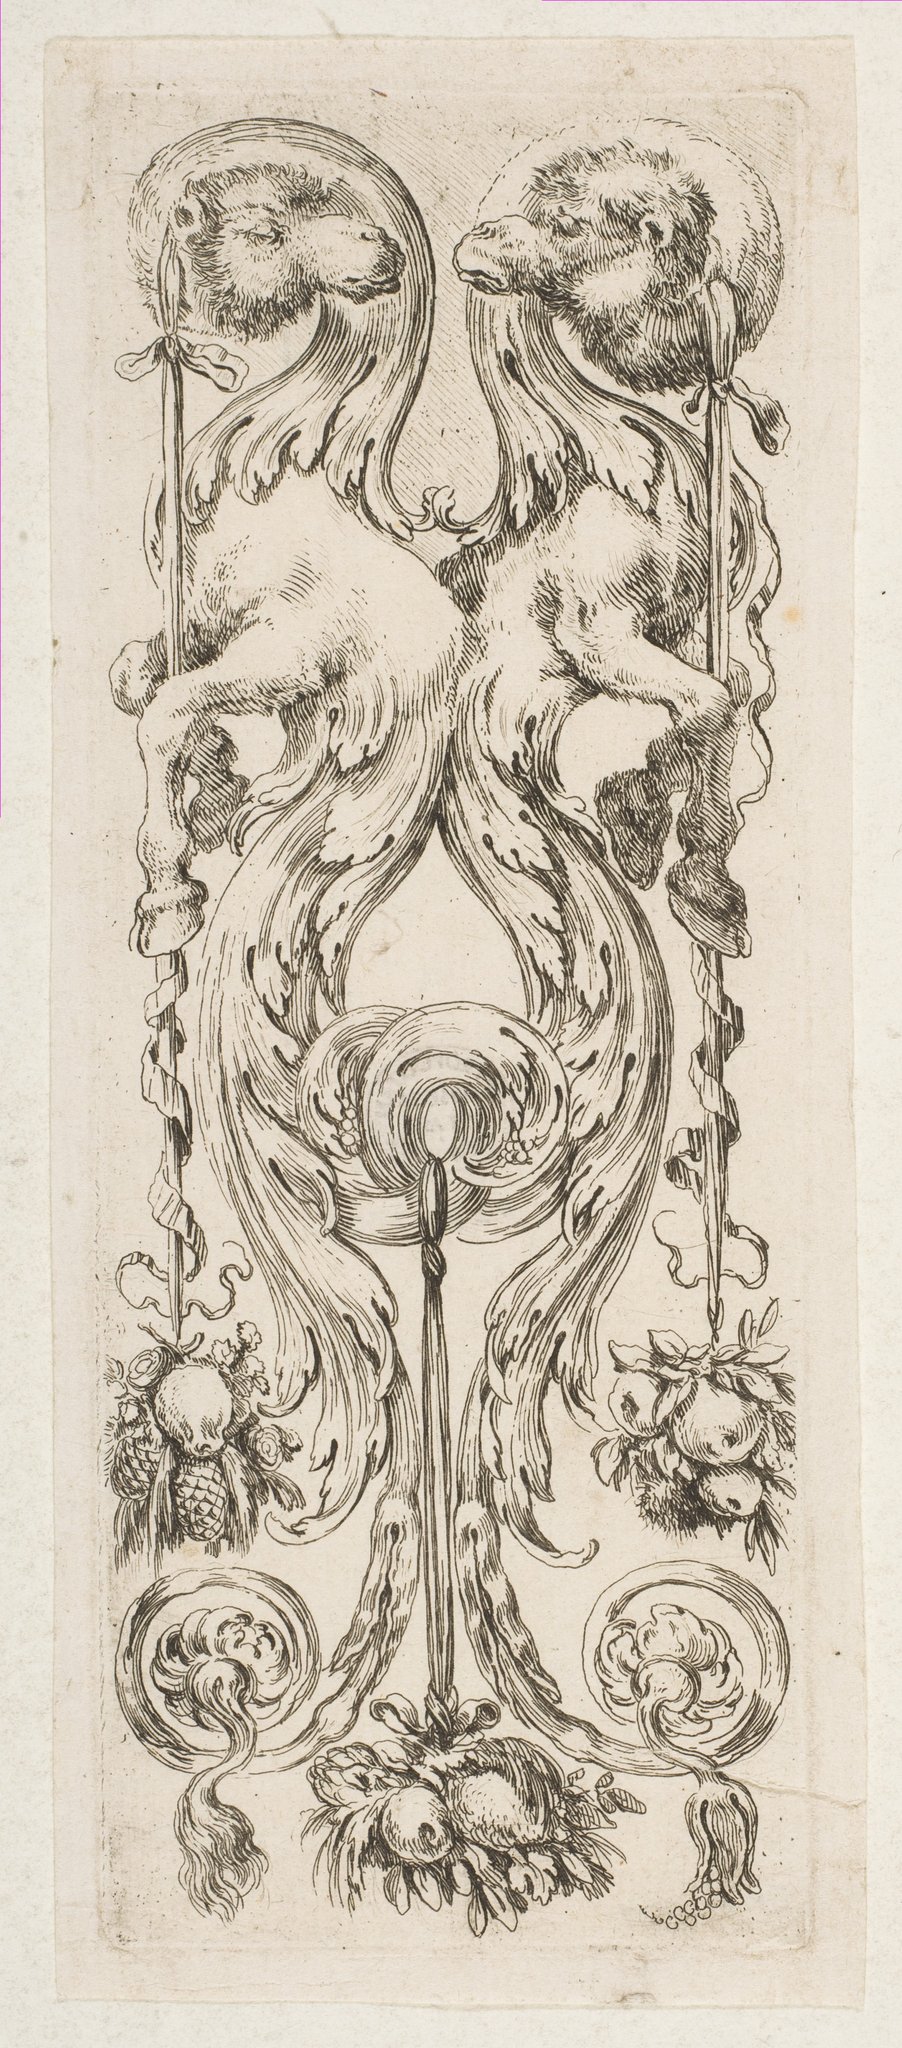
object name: print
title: Two Facing Camel Heads with Bodies Terminating in Ornament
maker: stefano della bella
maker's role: artist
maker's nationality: italian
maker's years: 1610-1664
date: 1653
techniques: etching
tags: fruit,camels